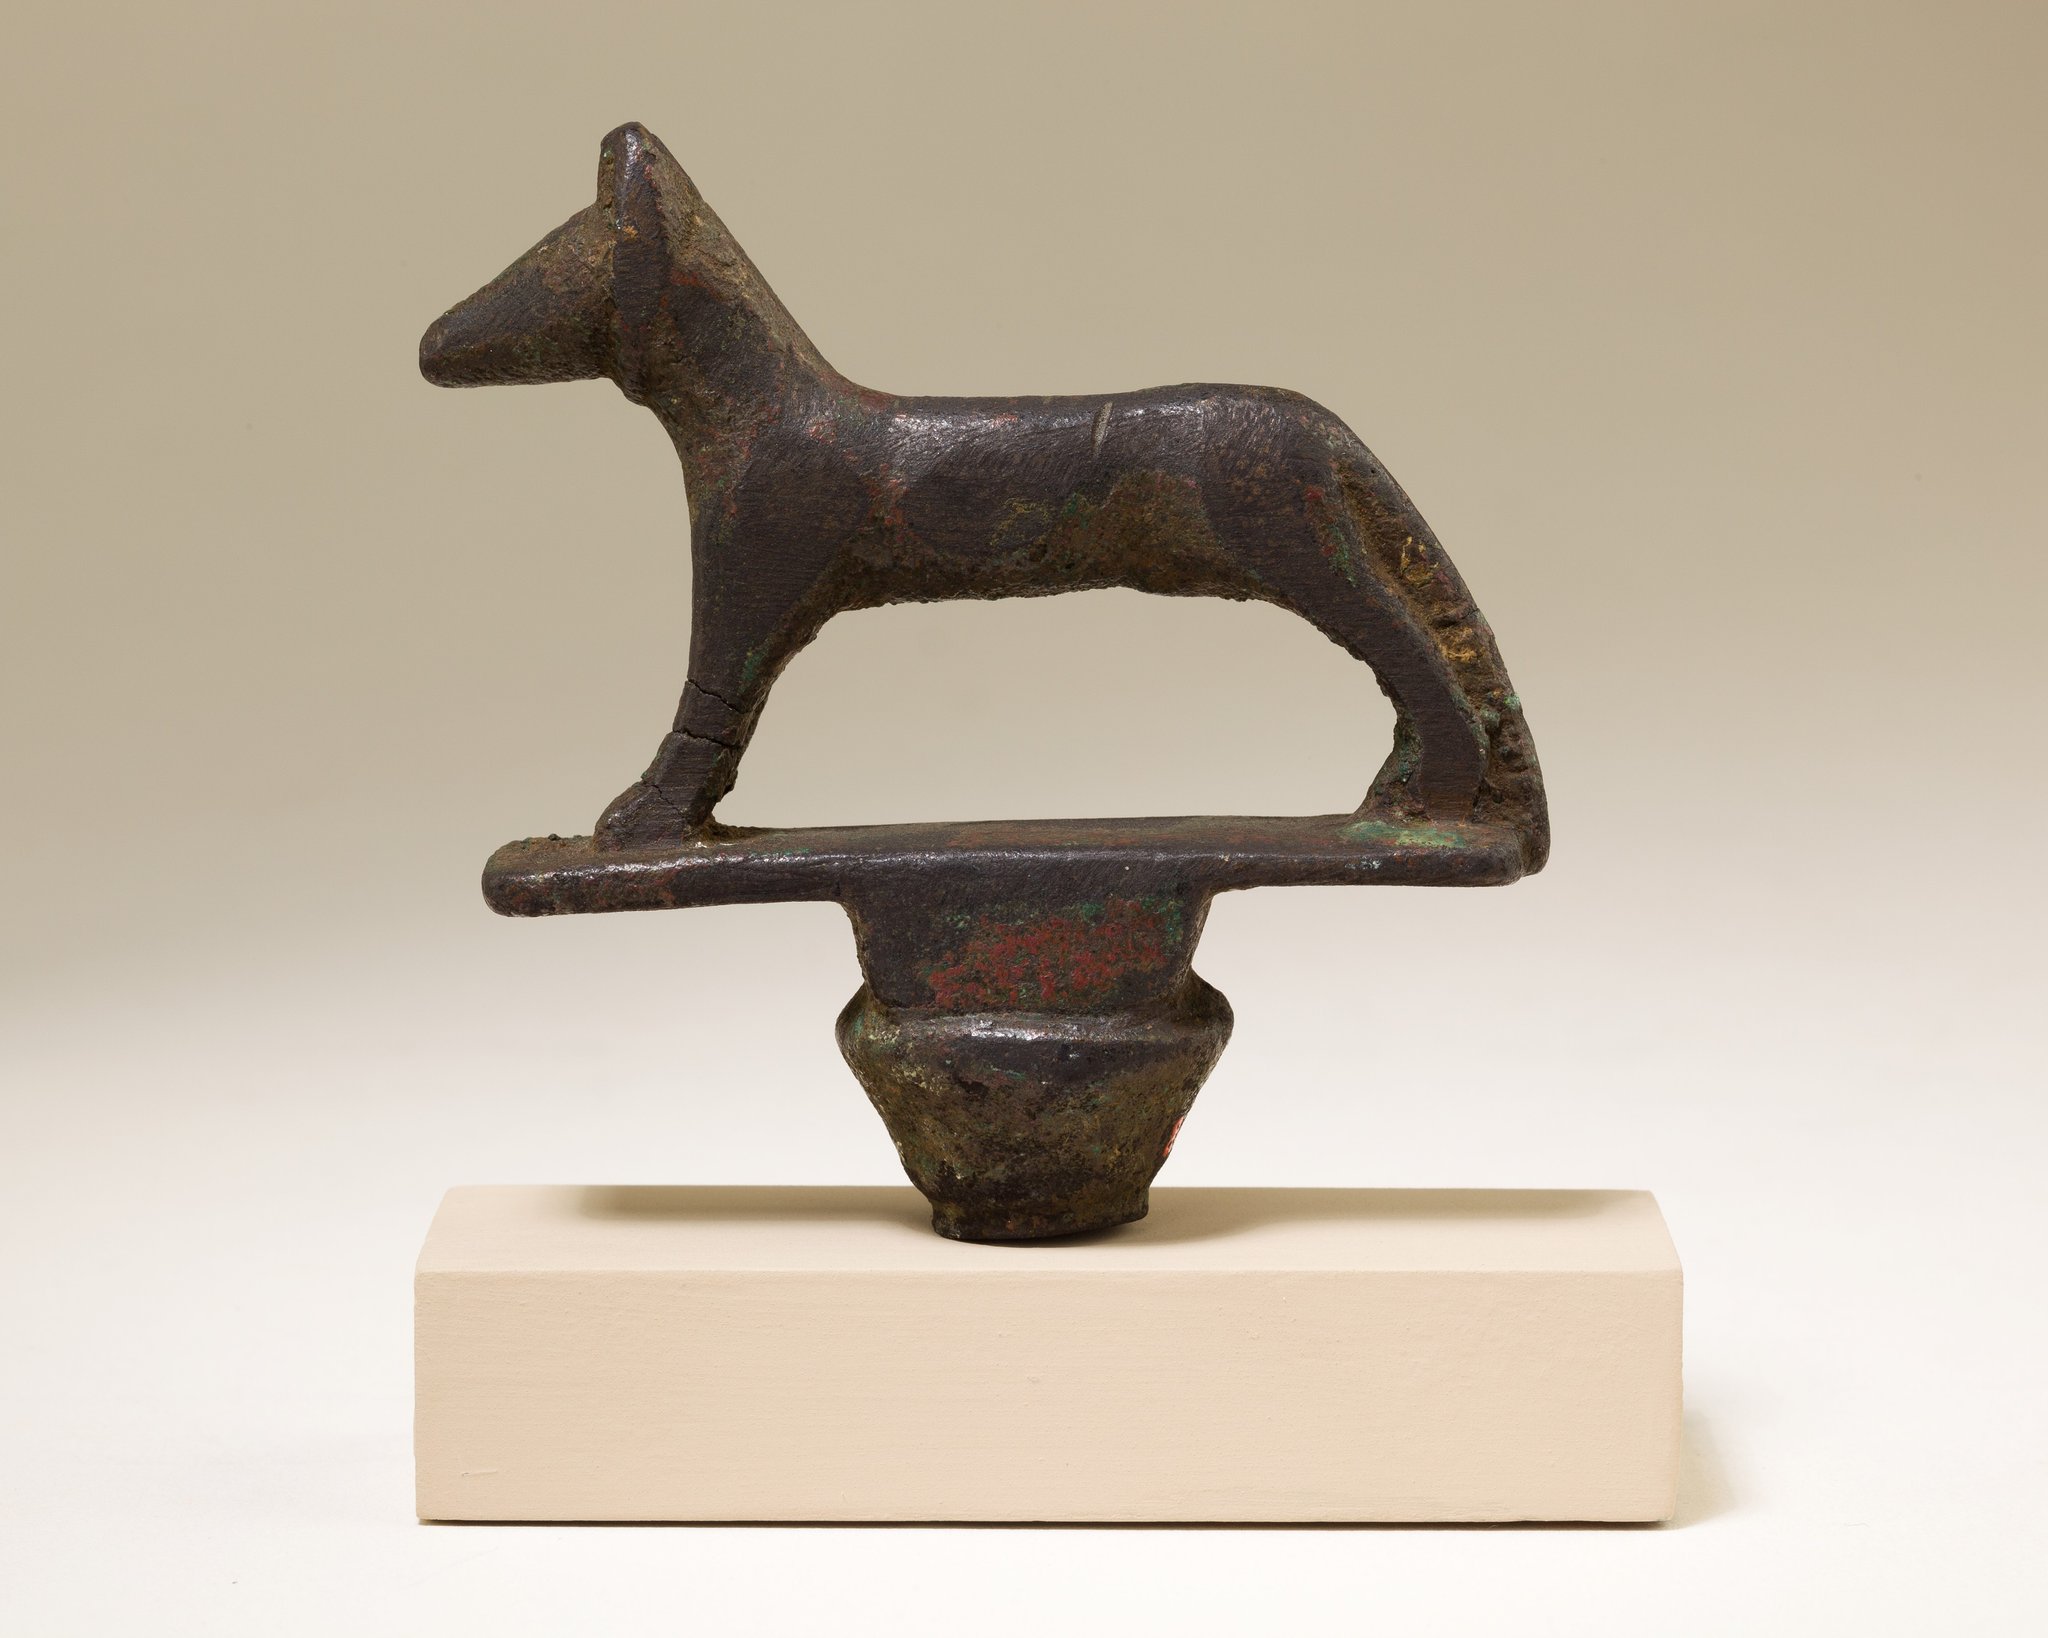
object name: figurine, jackal standard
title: Jackal standard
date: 664-630 BCE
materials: metal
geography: egypt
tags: jackals